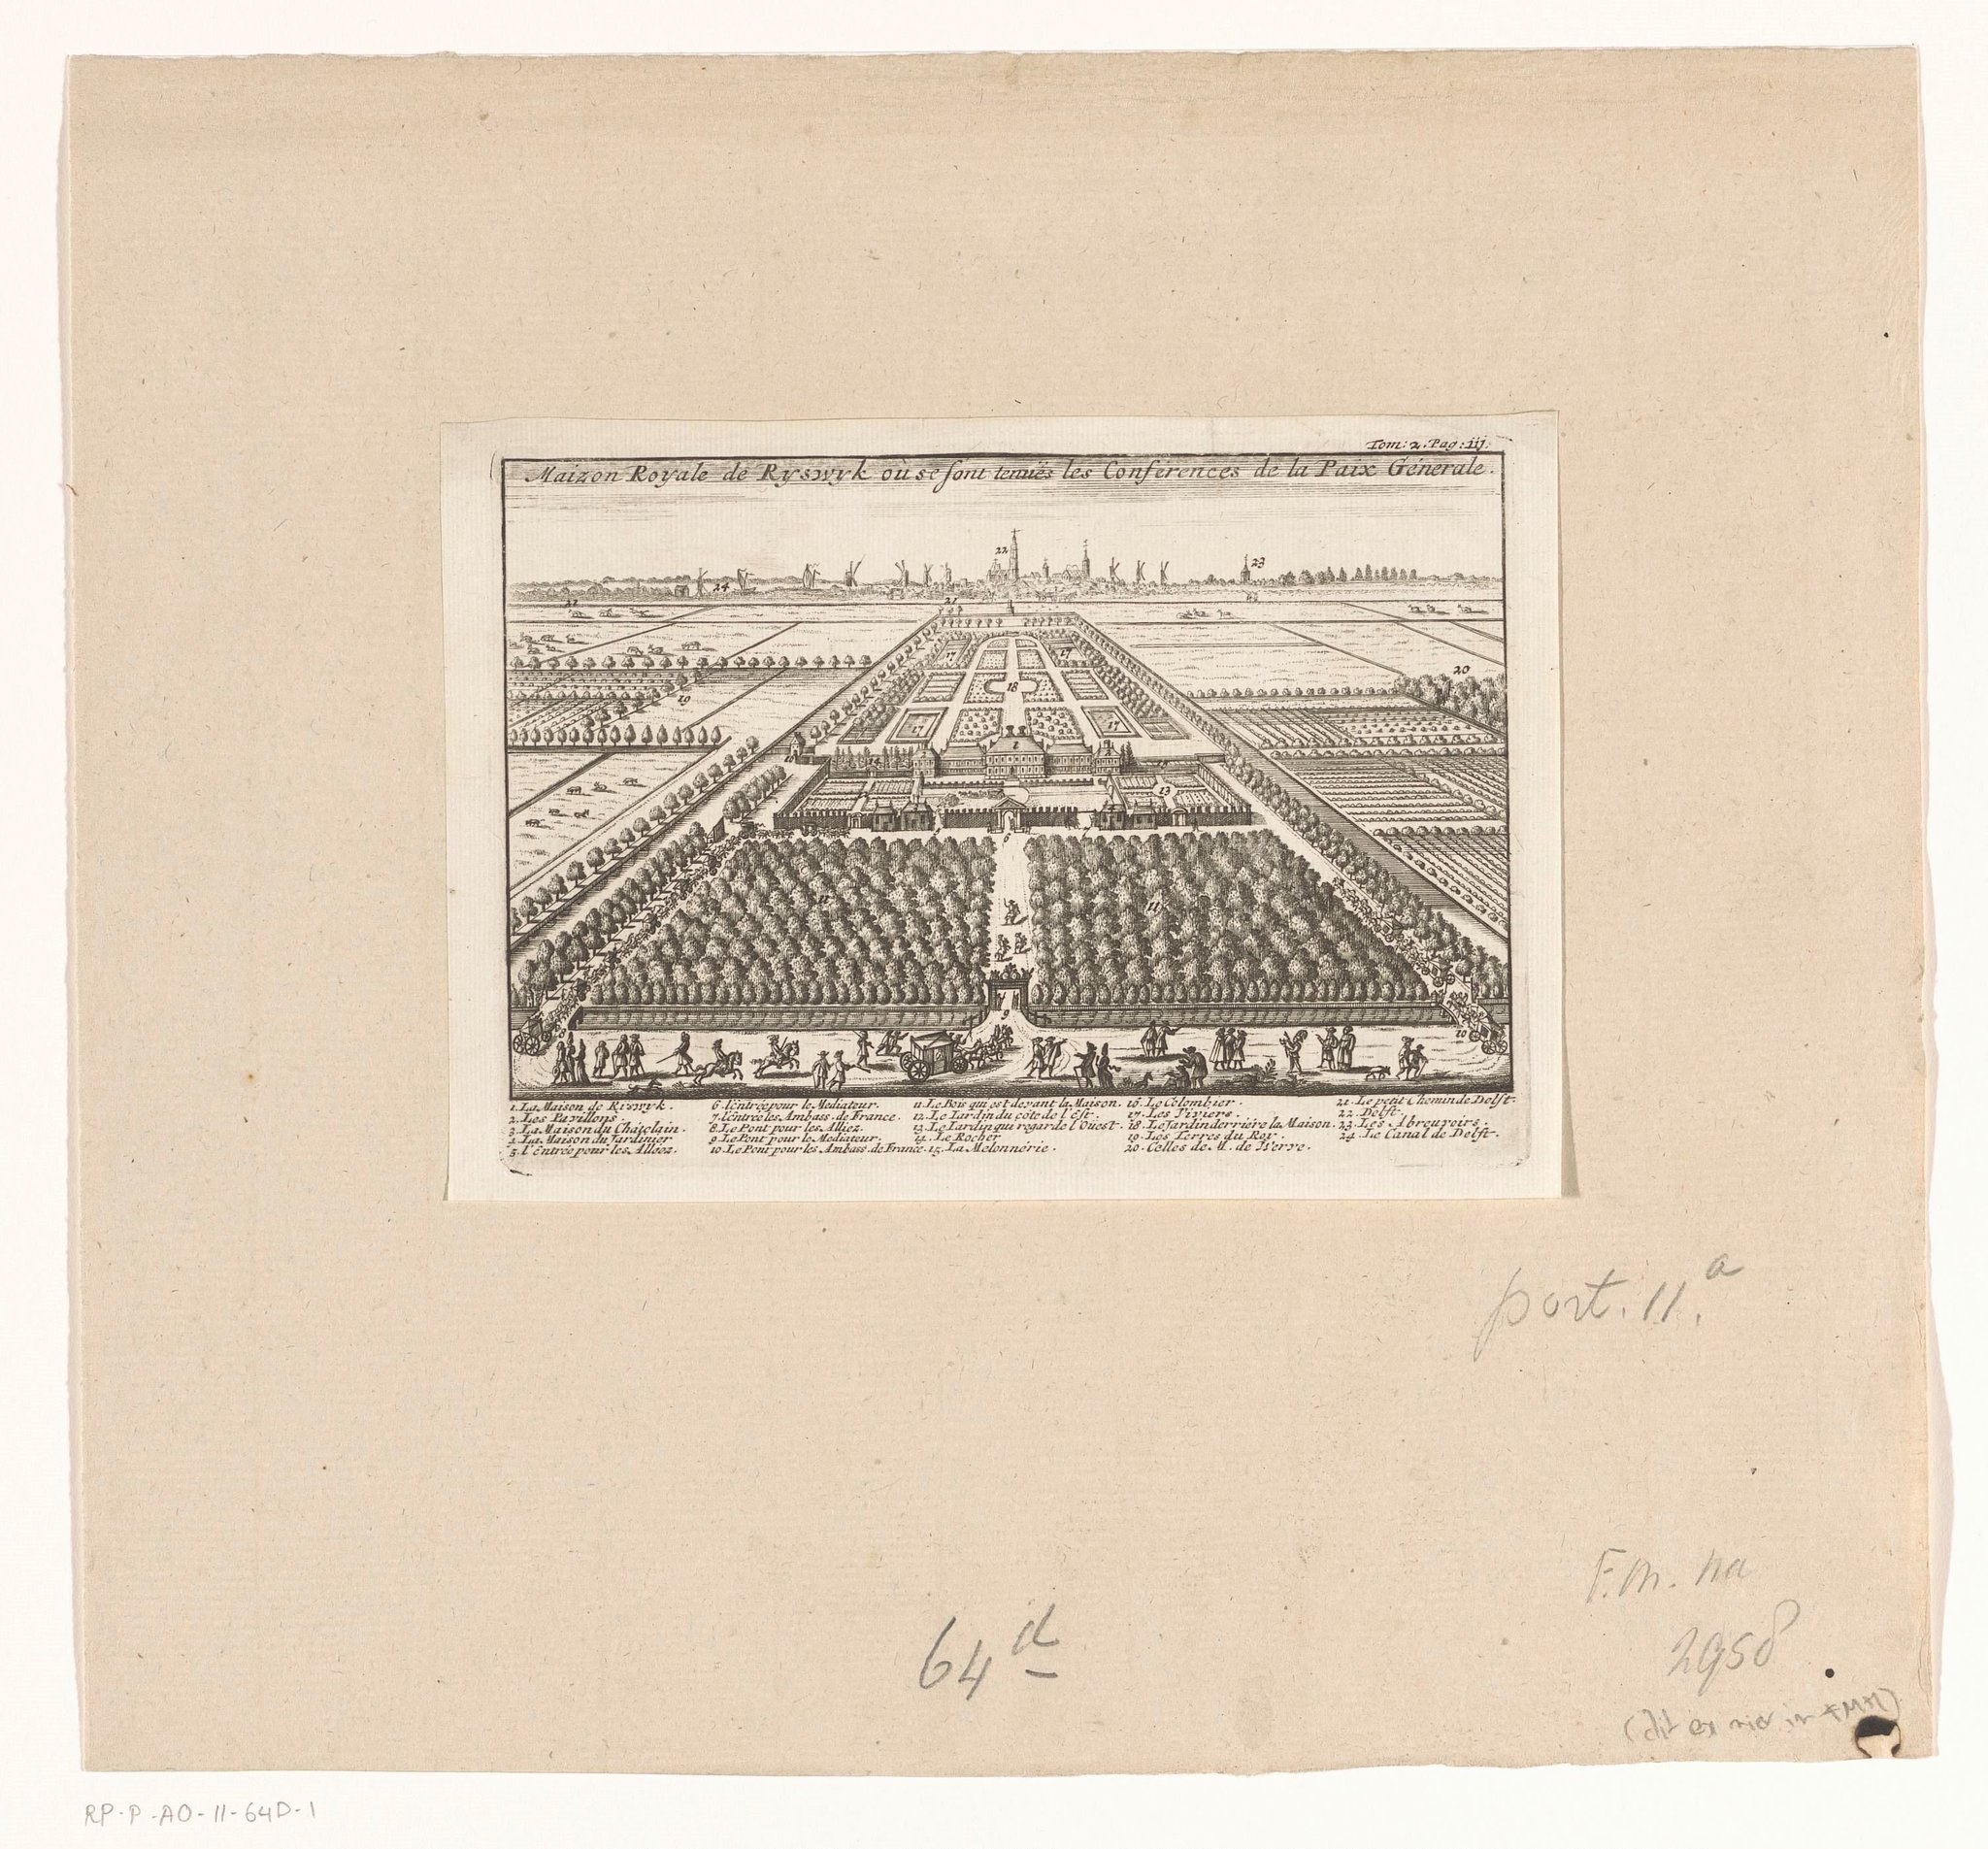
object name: book illustration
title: Gezicht op de tuinen bij het Huis ter Nieuburch in Rijswijk, 1697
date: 1699-1707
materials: paper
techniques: engraving, etching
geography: the hague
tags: garden, palace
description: Gezicht in vogelvluchtperspectief op het Huis ter Nieuburch met de tuinen te Rijswijk. Hier werden de onderhandelingen voor de Vrede van Rijswijk, gesloten op 20 september 1697, gehouden. Op de voorgrond de weg uit Den Haag met de drie bruggen en de drie aparte ingangen tot het paleis, in het verschiet Delft. In het onderschrift de legenda 1-24 in het Frans. Rechtsboven gemerkt: Tom: 2. Pag: iij.